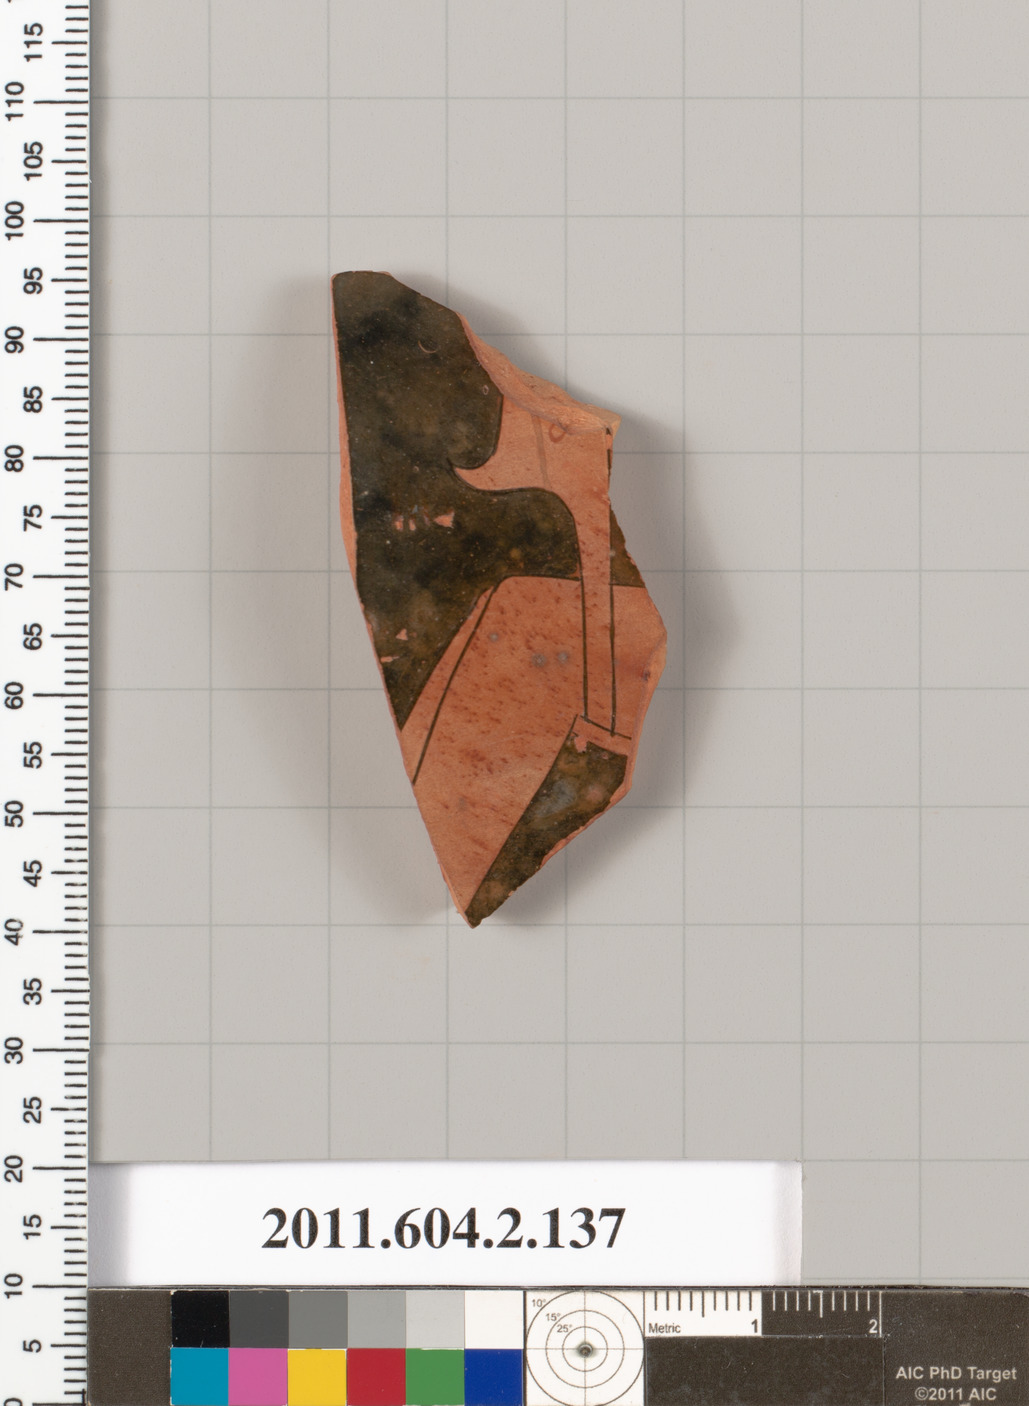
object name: pelike fragment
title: Terracotta fragment of a pelike (jar)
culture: greek, attic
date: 500-480 BCE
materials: terracotta